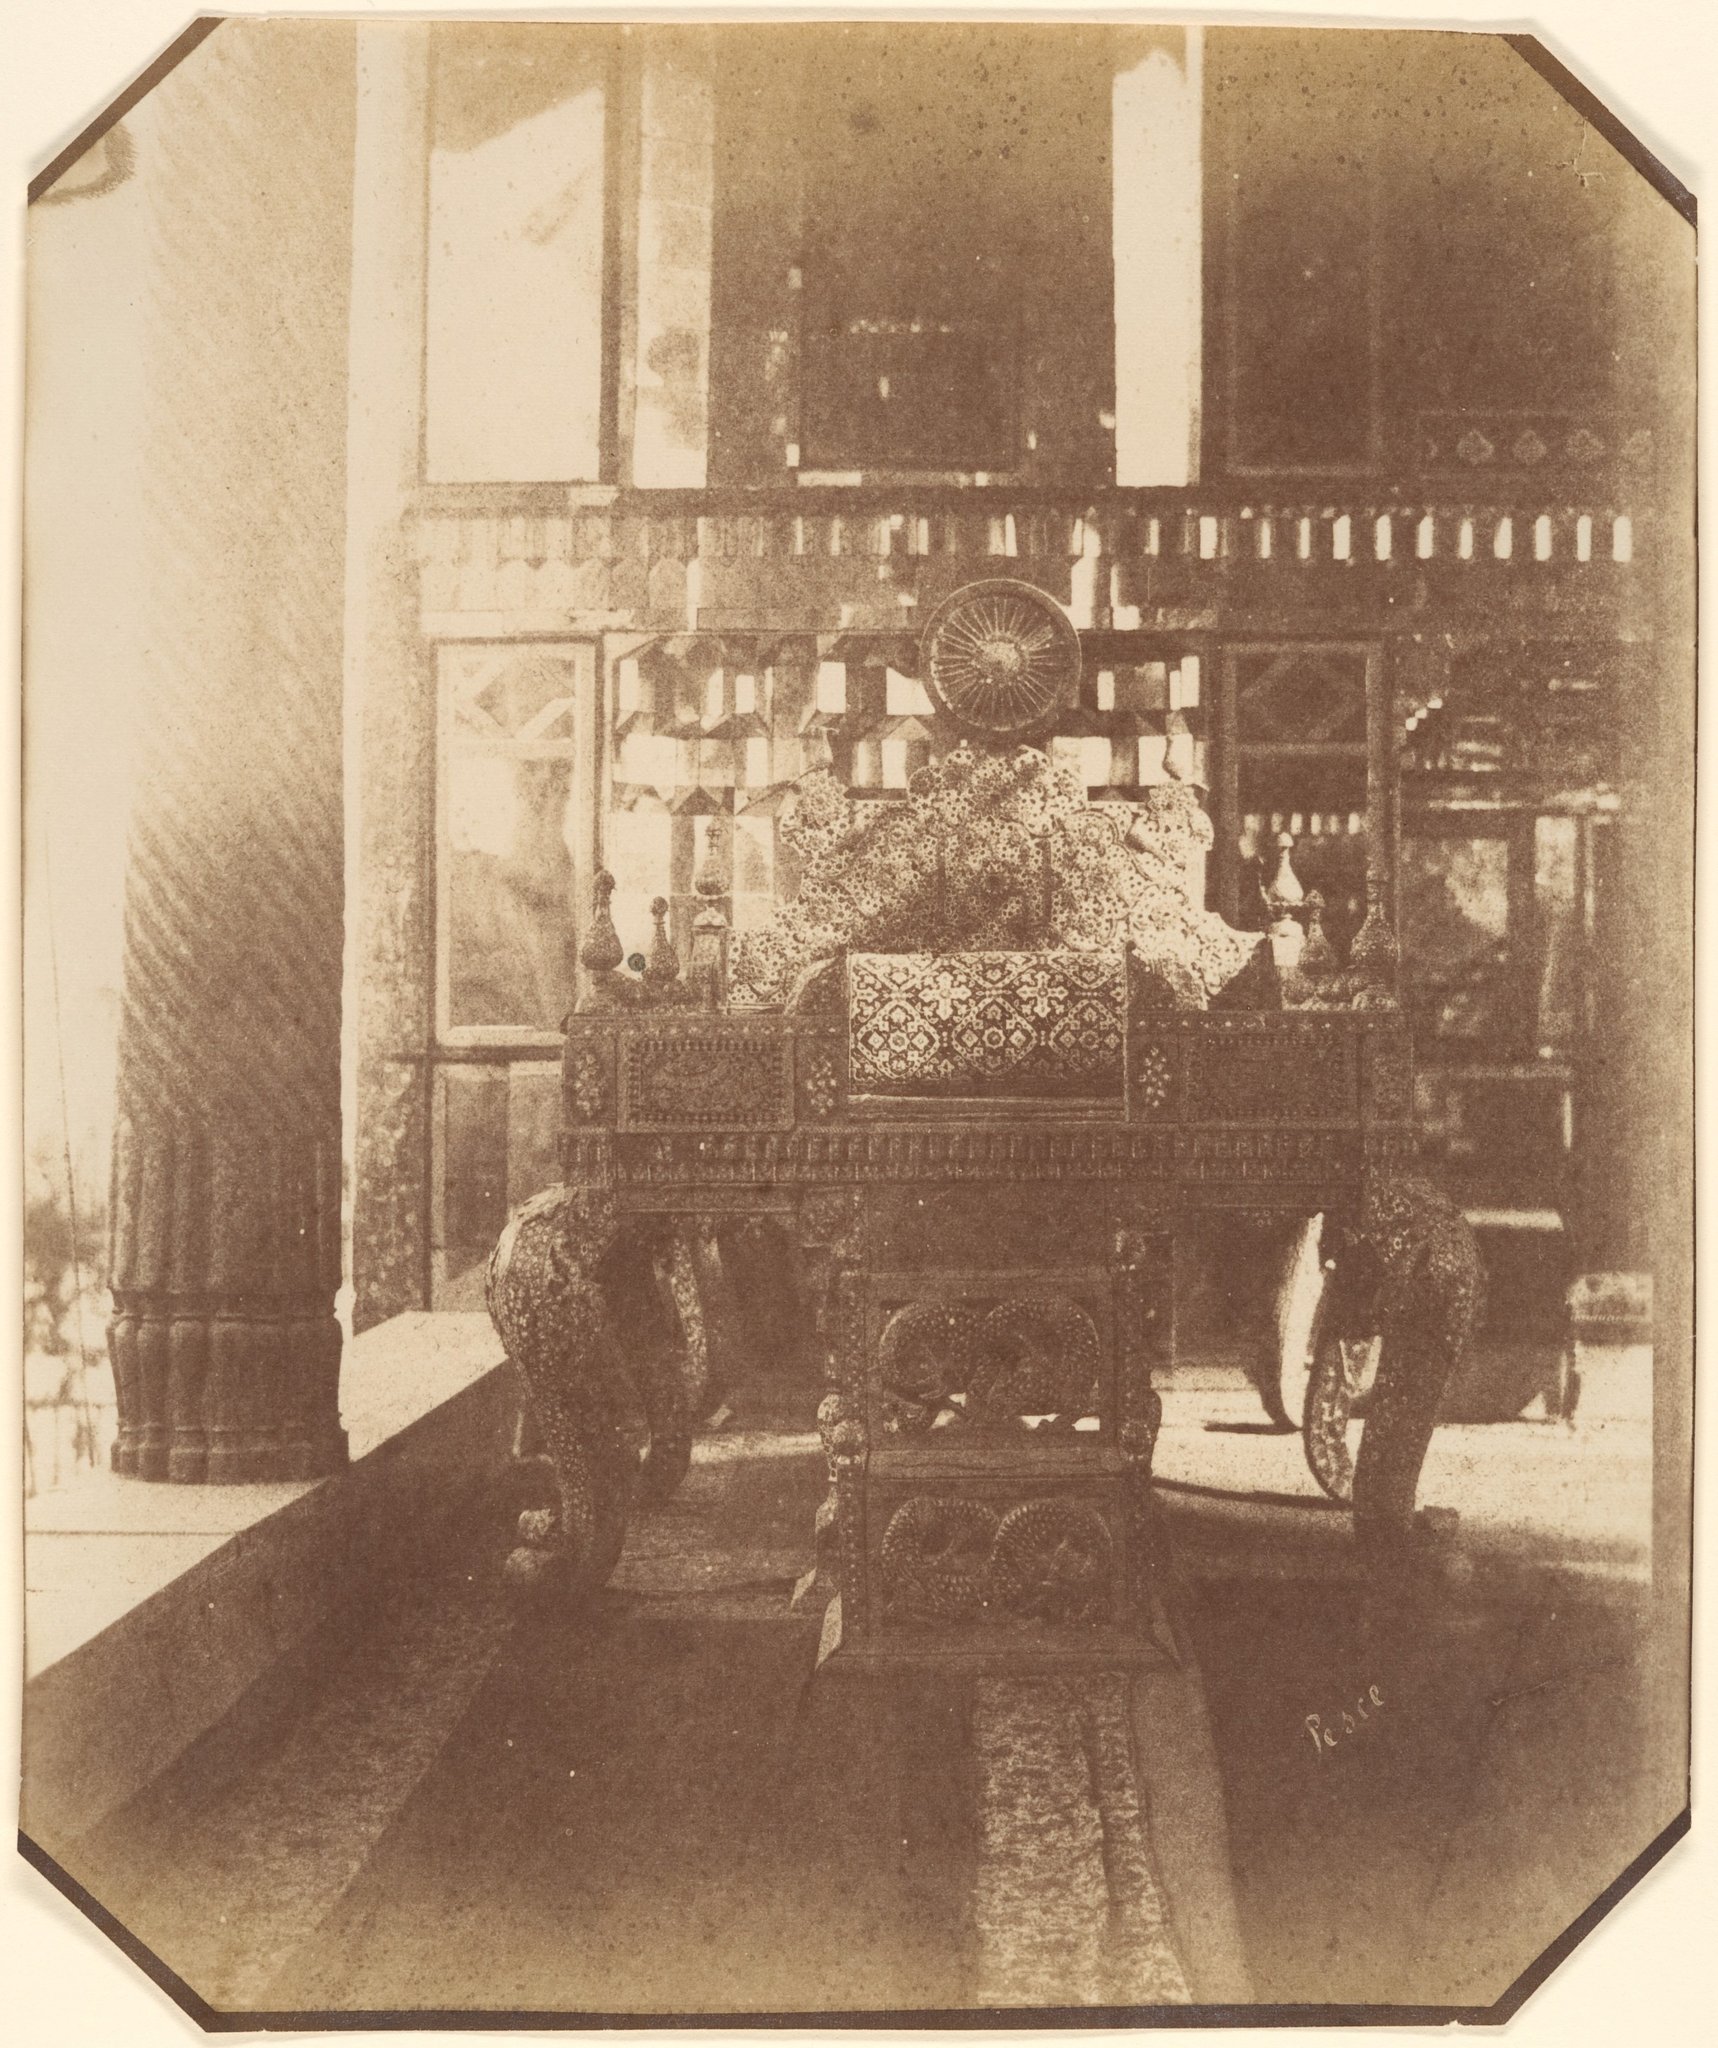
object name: photograph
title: [Golestan, The Peacock Throne, Teheran, Iran] (Takht-I Taous)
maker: luigi pesce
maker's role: artist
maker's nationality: italian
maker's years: 1818-1891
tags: thrones